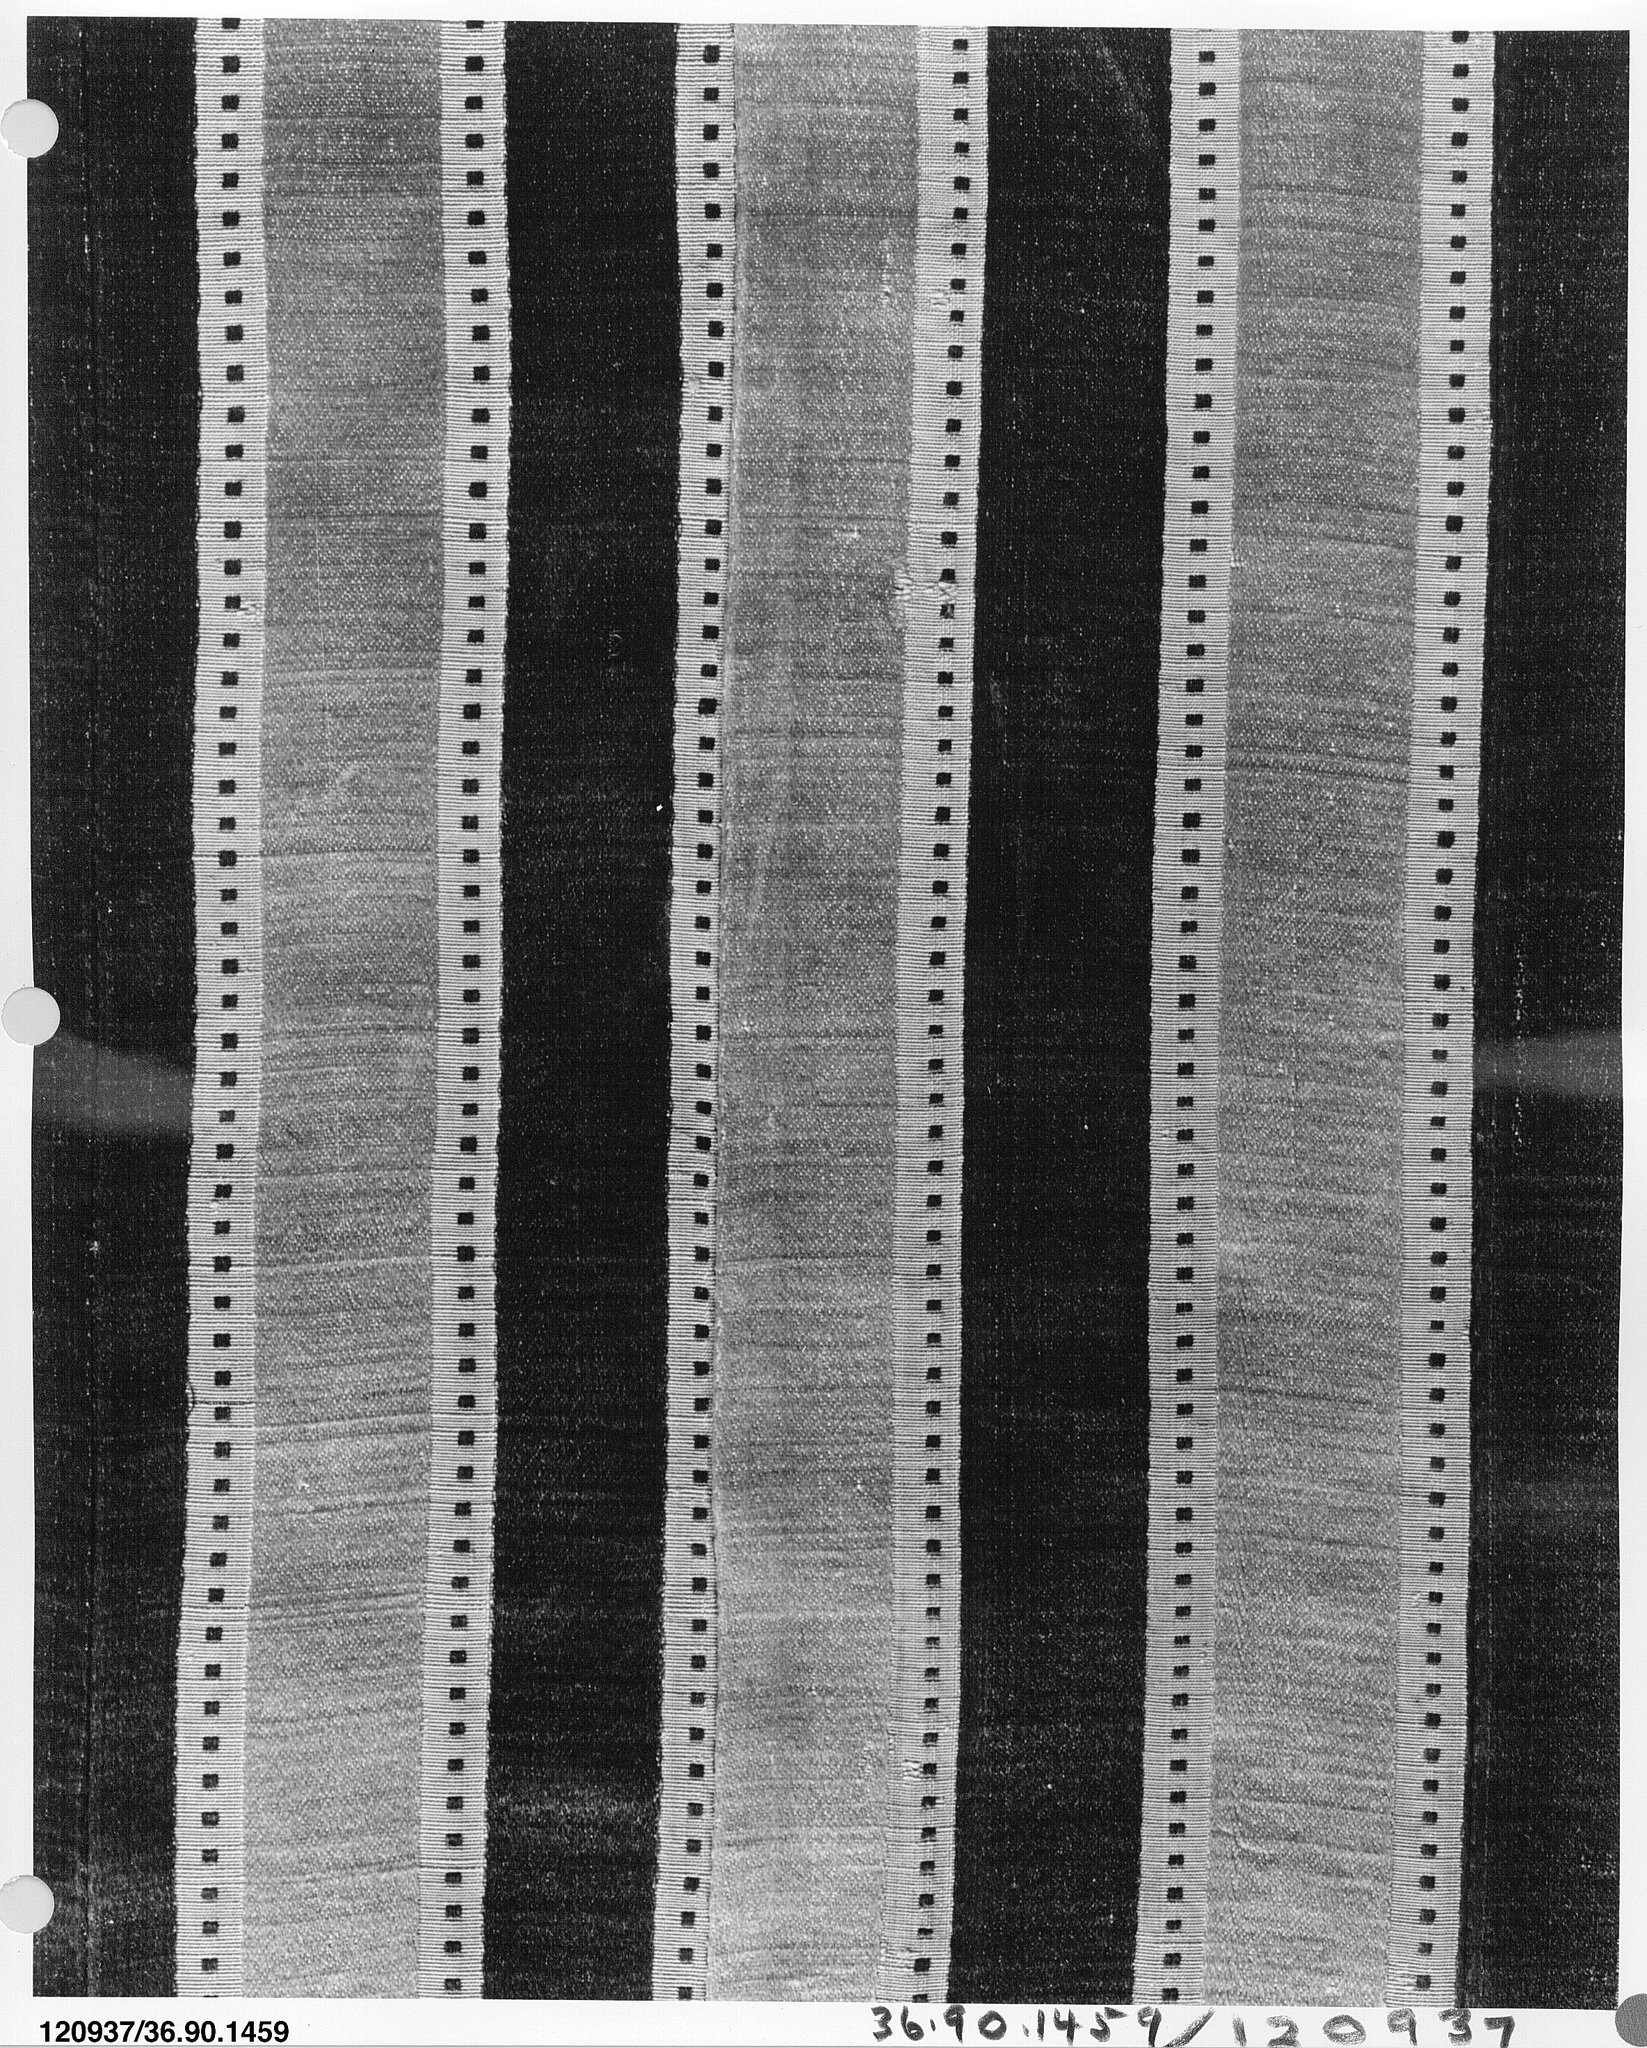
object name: piece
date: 1701-1800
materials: silk